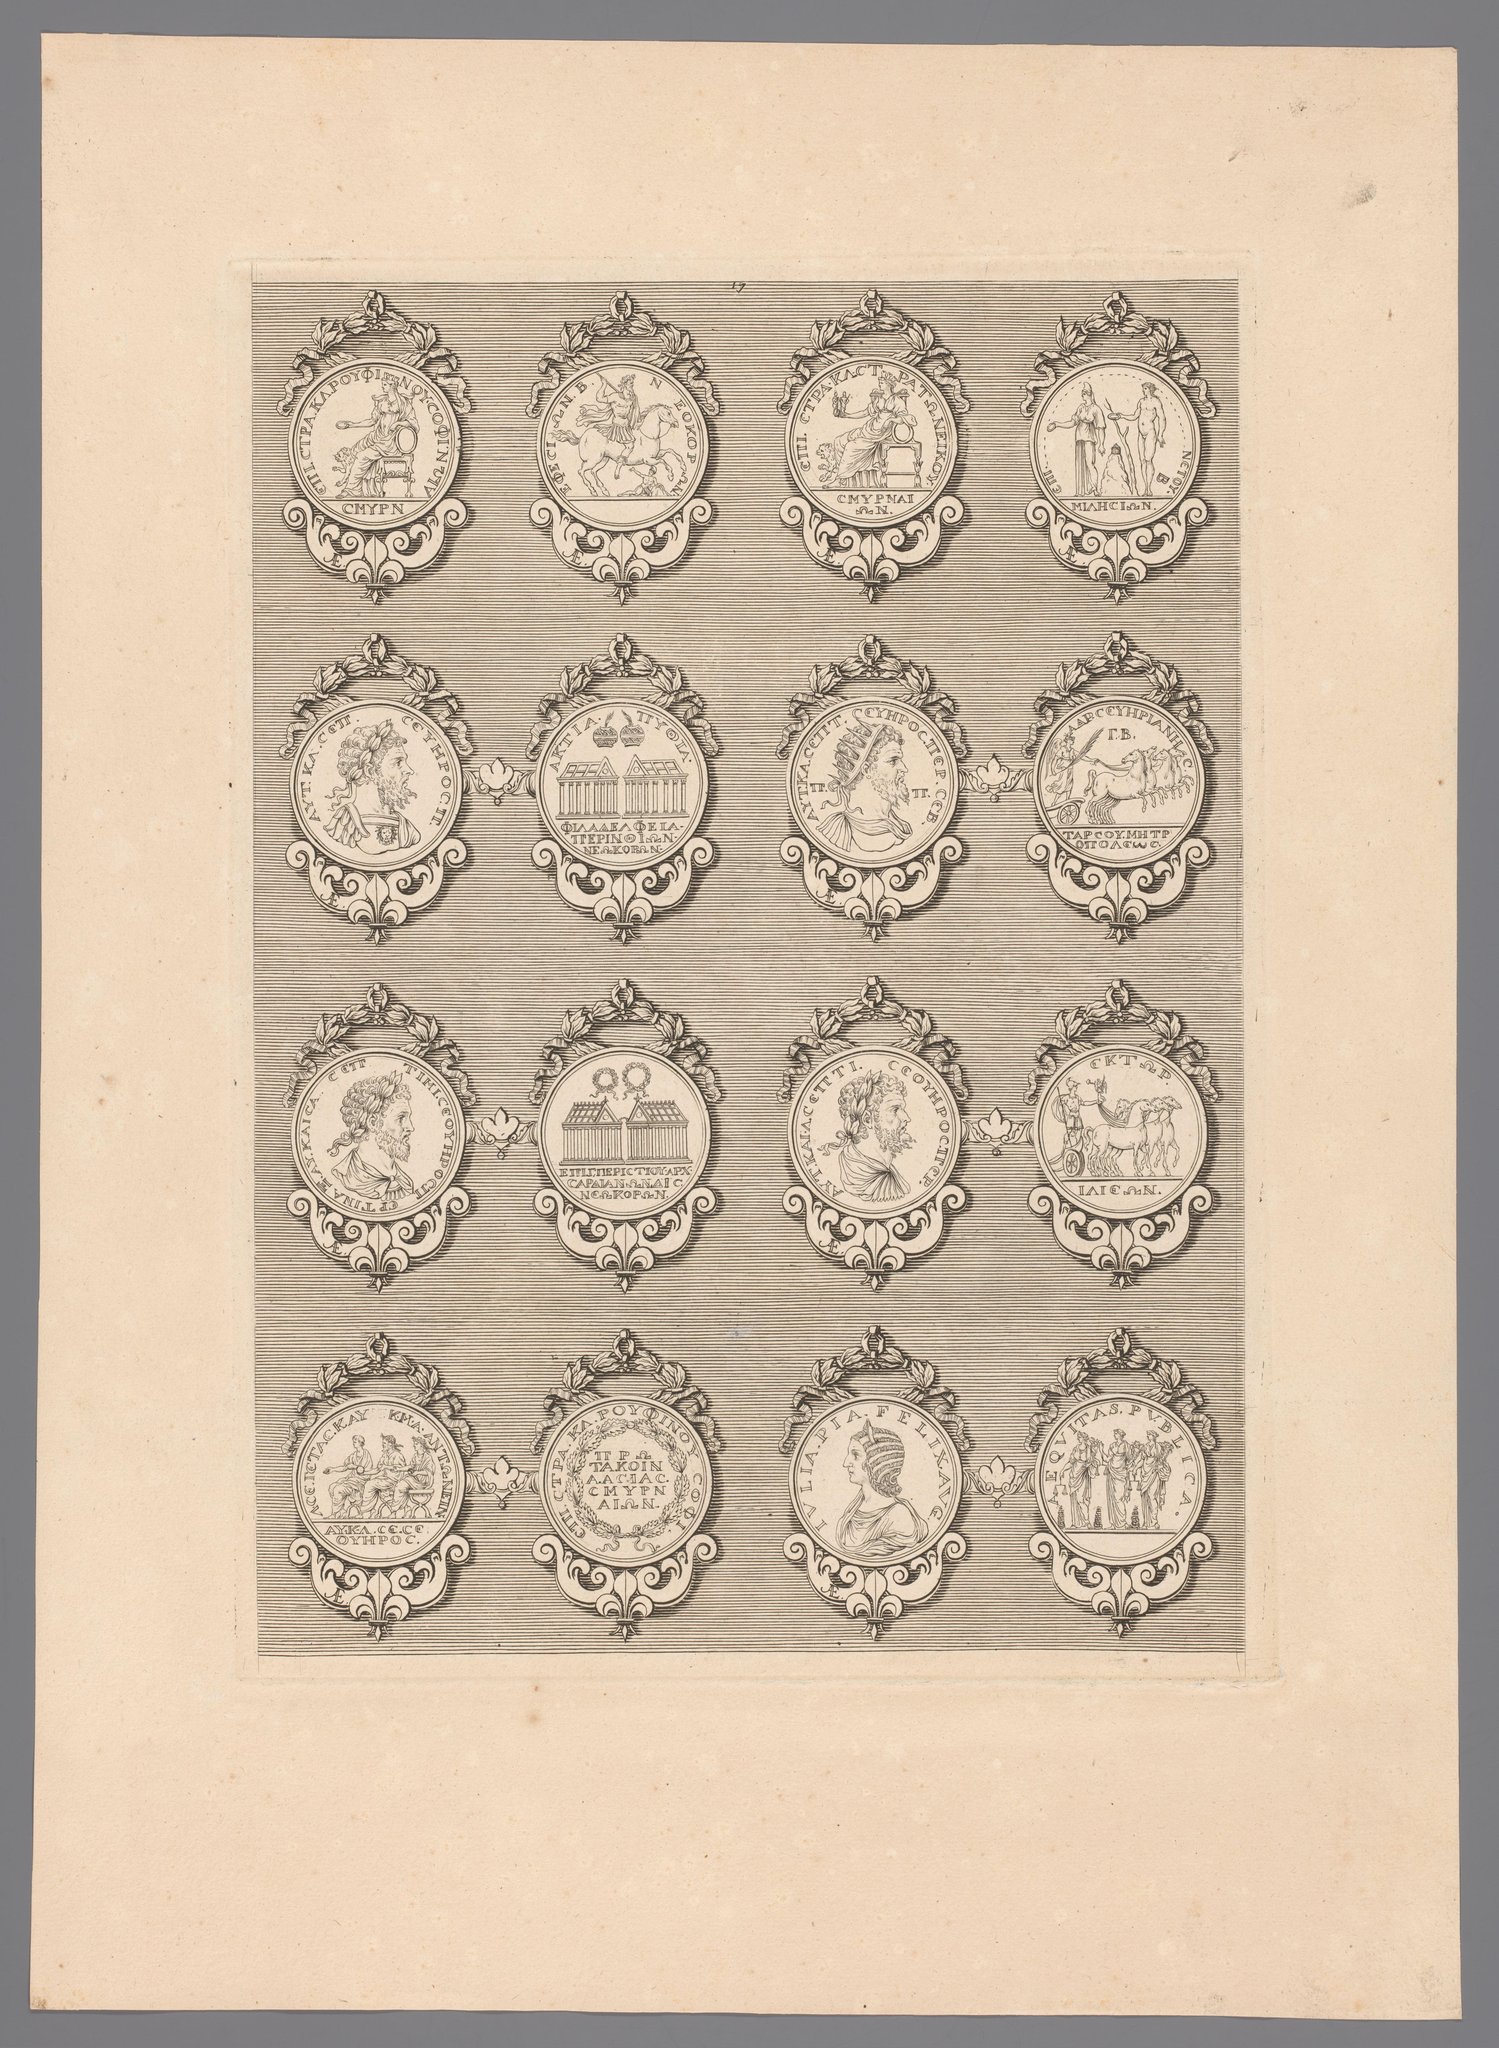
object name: print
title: Zestien penningen met versierde lijsten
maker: simon de la boissière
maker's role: print maker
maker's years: 1637-1682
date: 1647-1682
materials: paper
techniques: etching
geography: france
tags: medal (considered as a piece of sculpture, regardless of its specific function)